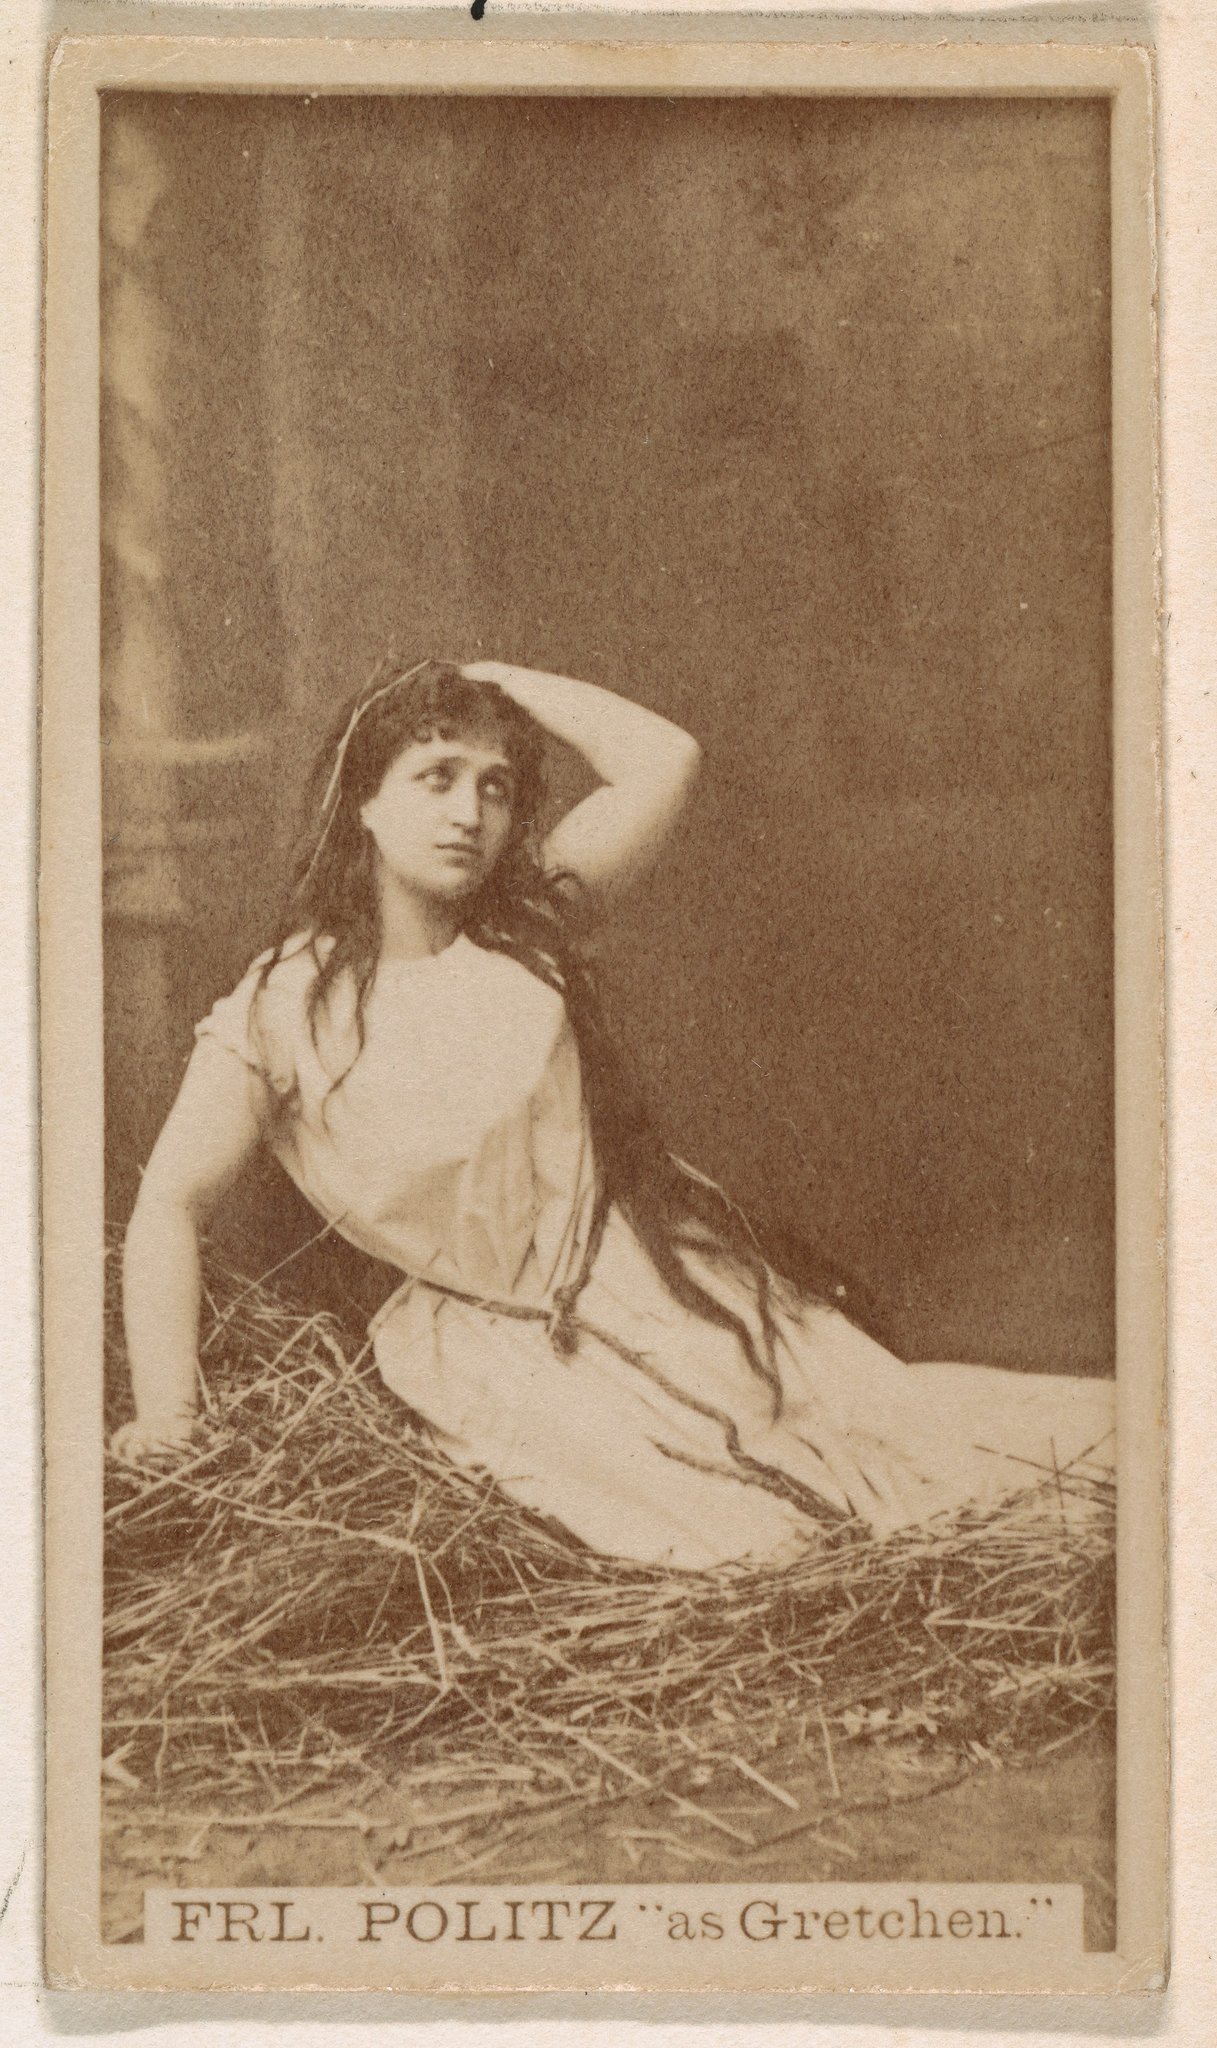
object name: photograph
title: Frl. Politz as Gretchen, from the Actresses series (N245) issued by Kinney Brothers to promote Sweet Caporal Cigarettes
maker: kinney brothers tobacco company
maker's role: publisher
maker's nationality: american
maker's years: 1869-2011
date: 1890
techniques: albumen silver print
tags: portraits,women,actresses